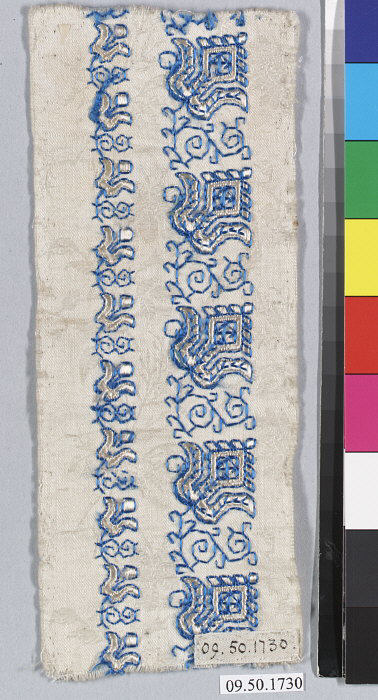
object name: fragment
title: Fragments (2)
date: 1801-1900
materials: linen, silk